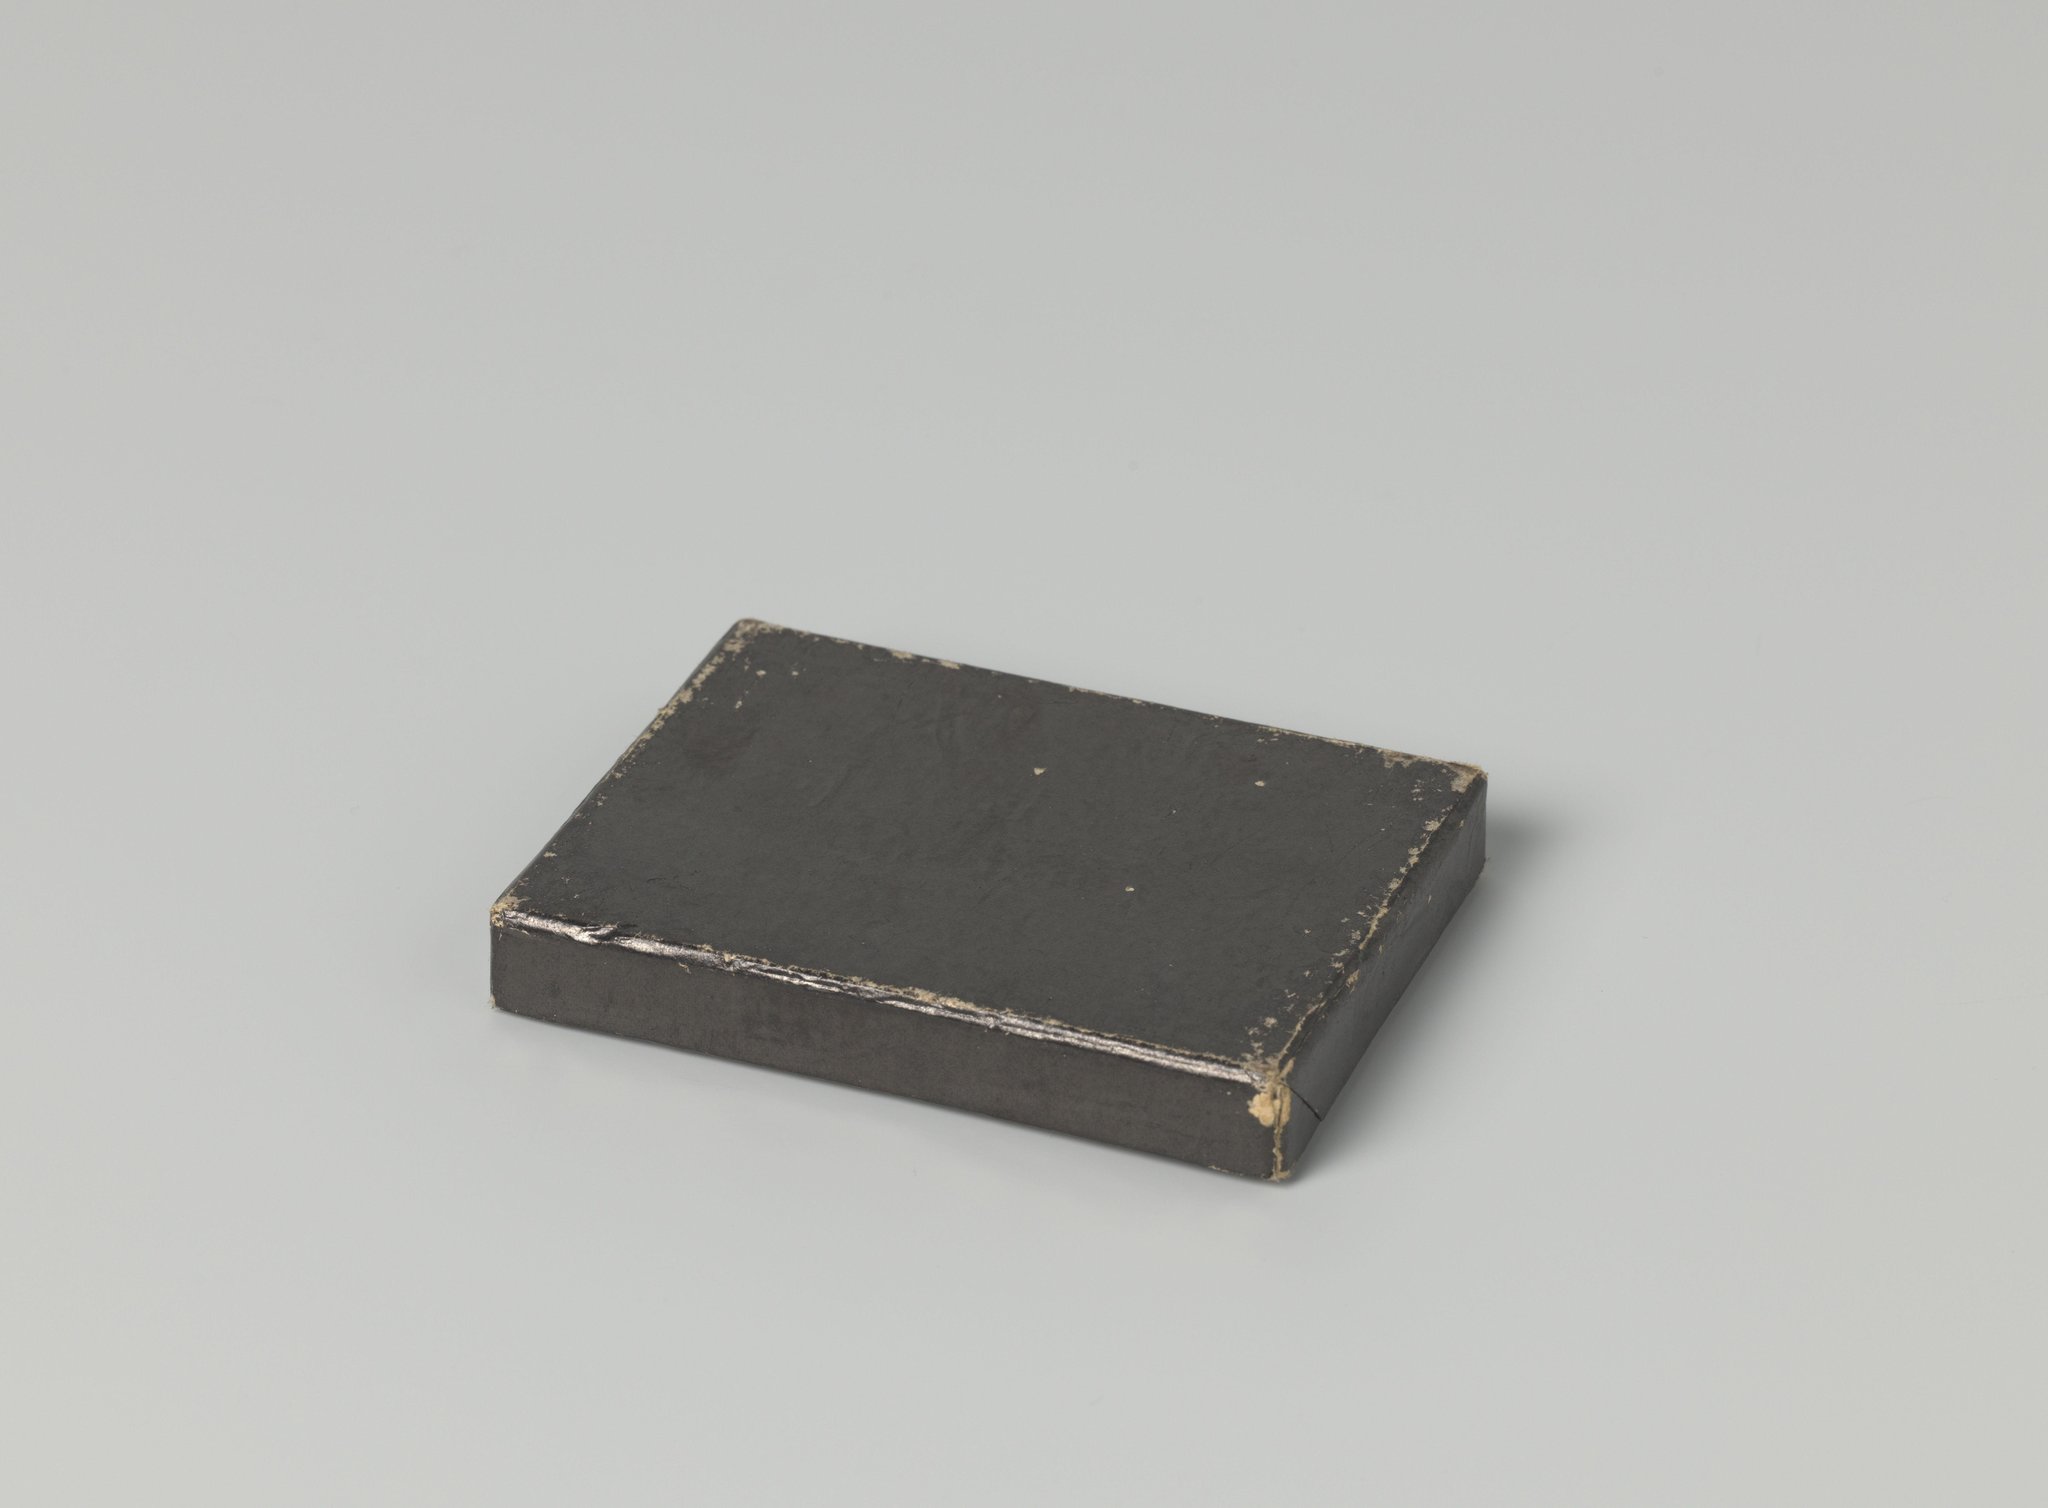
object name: box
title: Doos voor autochromes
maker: Anonymous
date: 1900-1930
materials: cardboard, paper